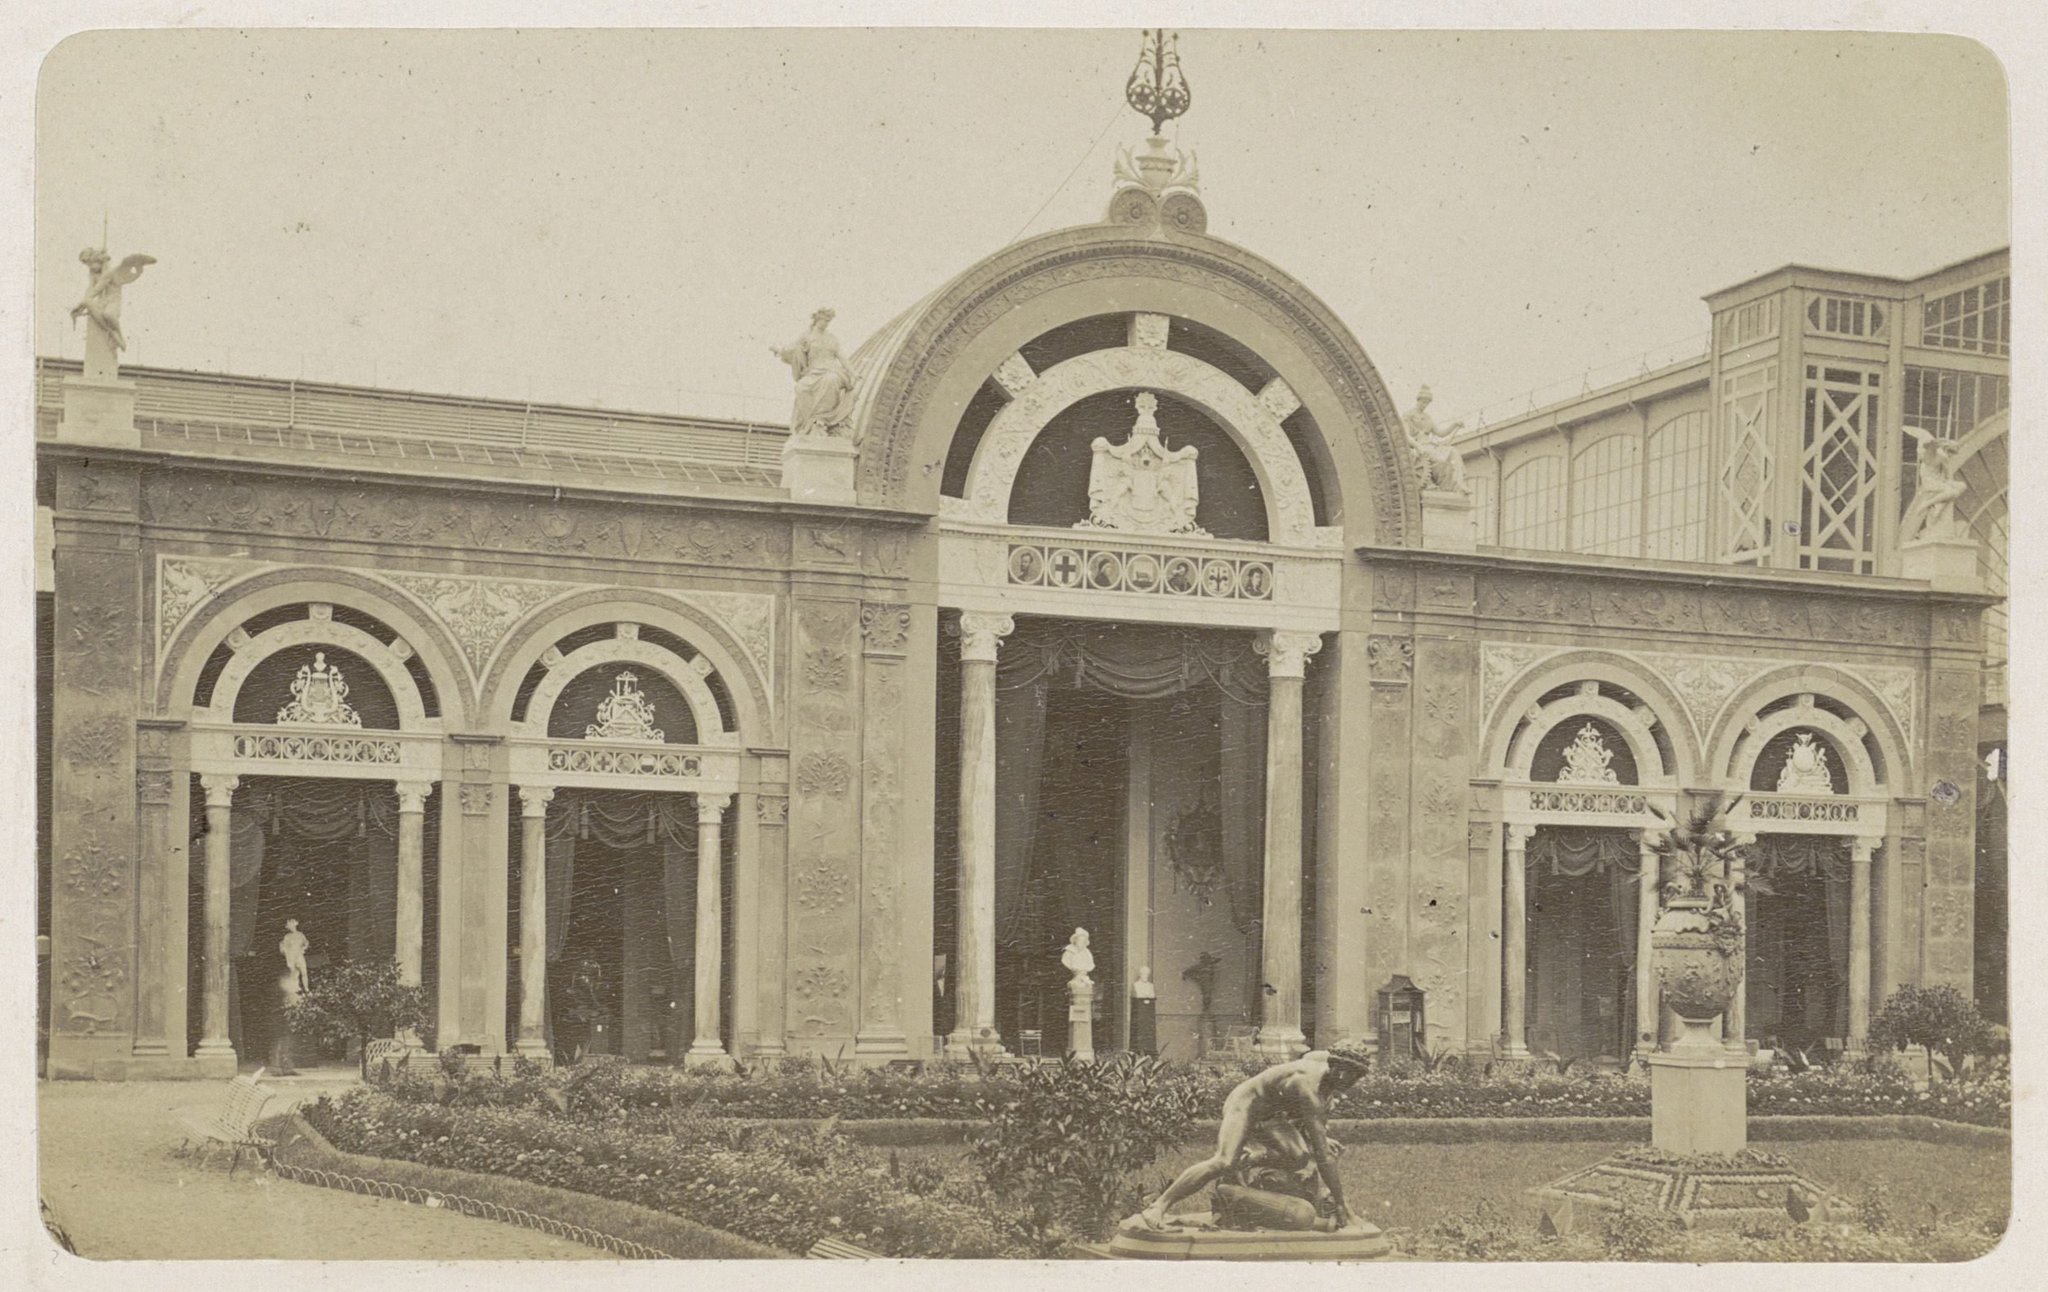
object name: photograph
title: Italiaans paviljoen op de Wereldtentoonstelling te Parijs in 1889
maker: Anonymous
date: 1889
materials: photographic support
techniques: albumen print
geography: paris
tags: world fair, world exhibition, façade (of house or building), paris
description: Onderdeel van Reisalbum Europese steden, vermoedelijk Zweeds.